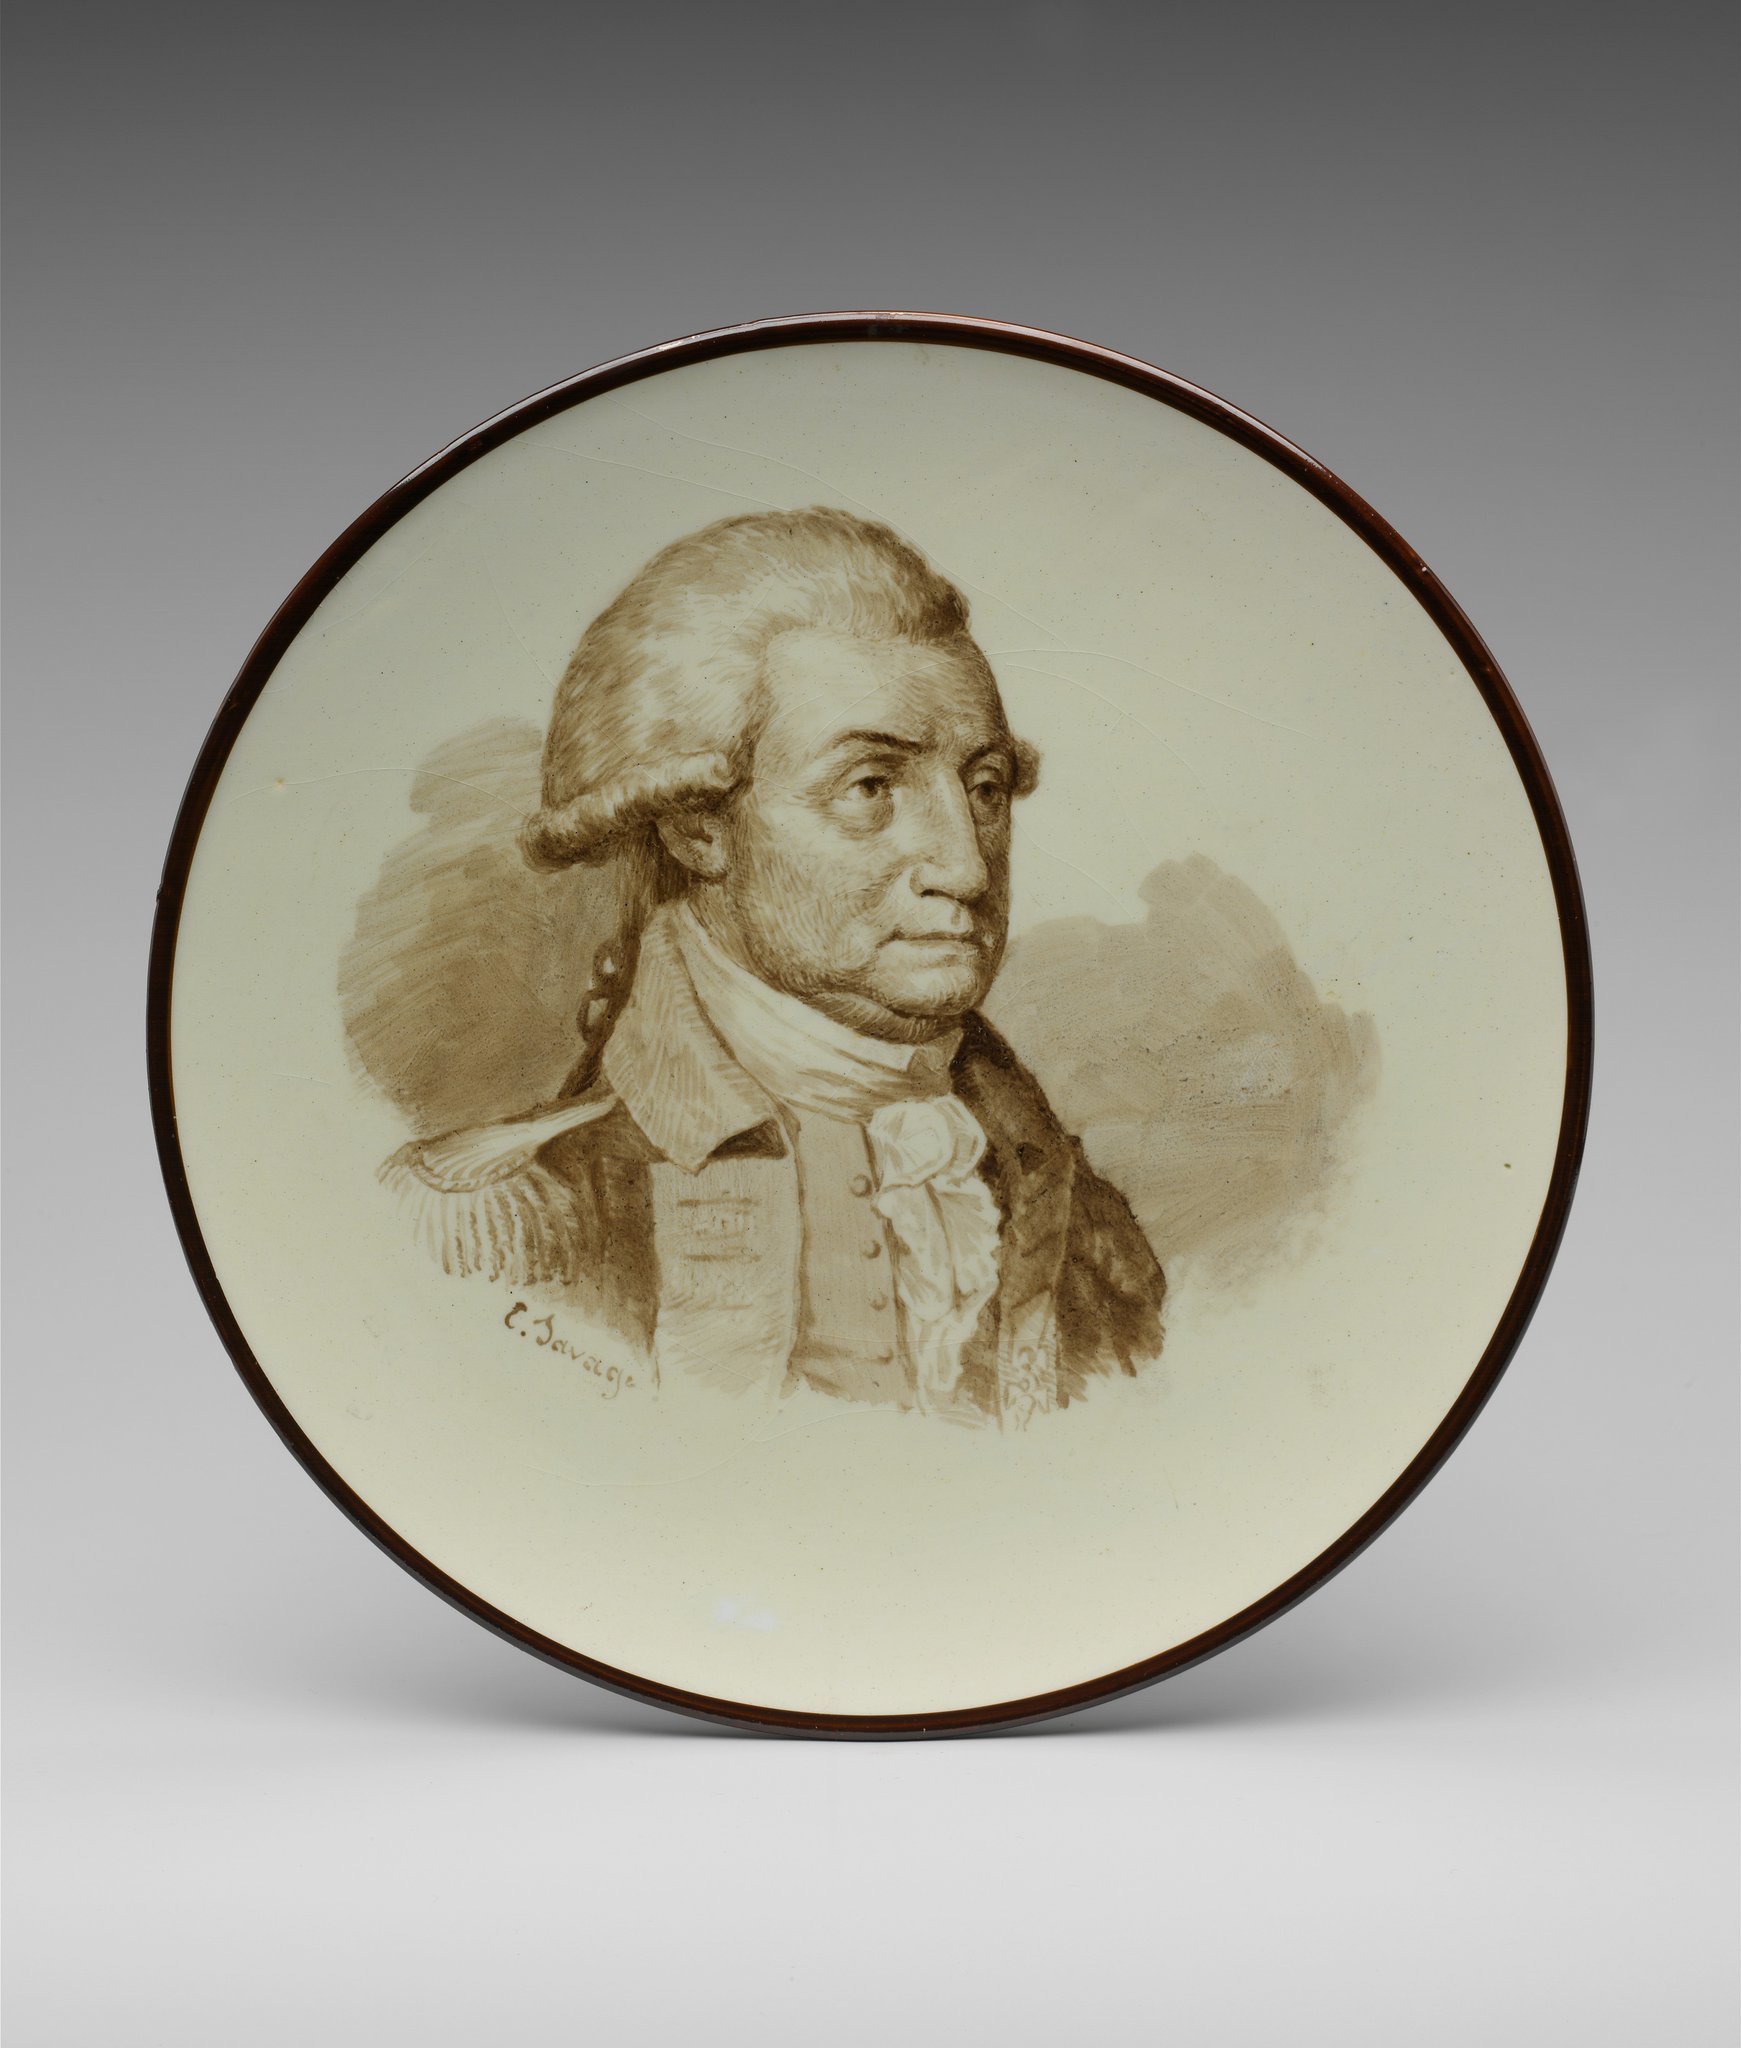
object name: plaque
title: George Washington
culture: french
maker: emile dupont-zipcy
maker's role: maker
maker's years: 1822-1885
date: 1840-1883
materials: faience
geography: france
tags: george washington,men,portraits